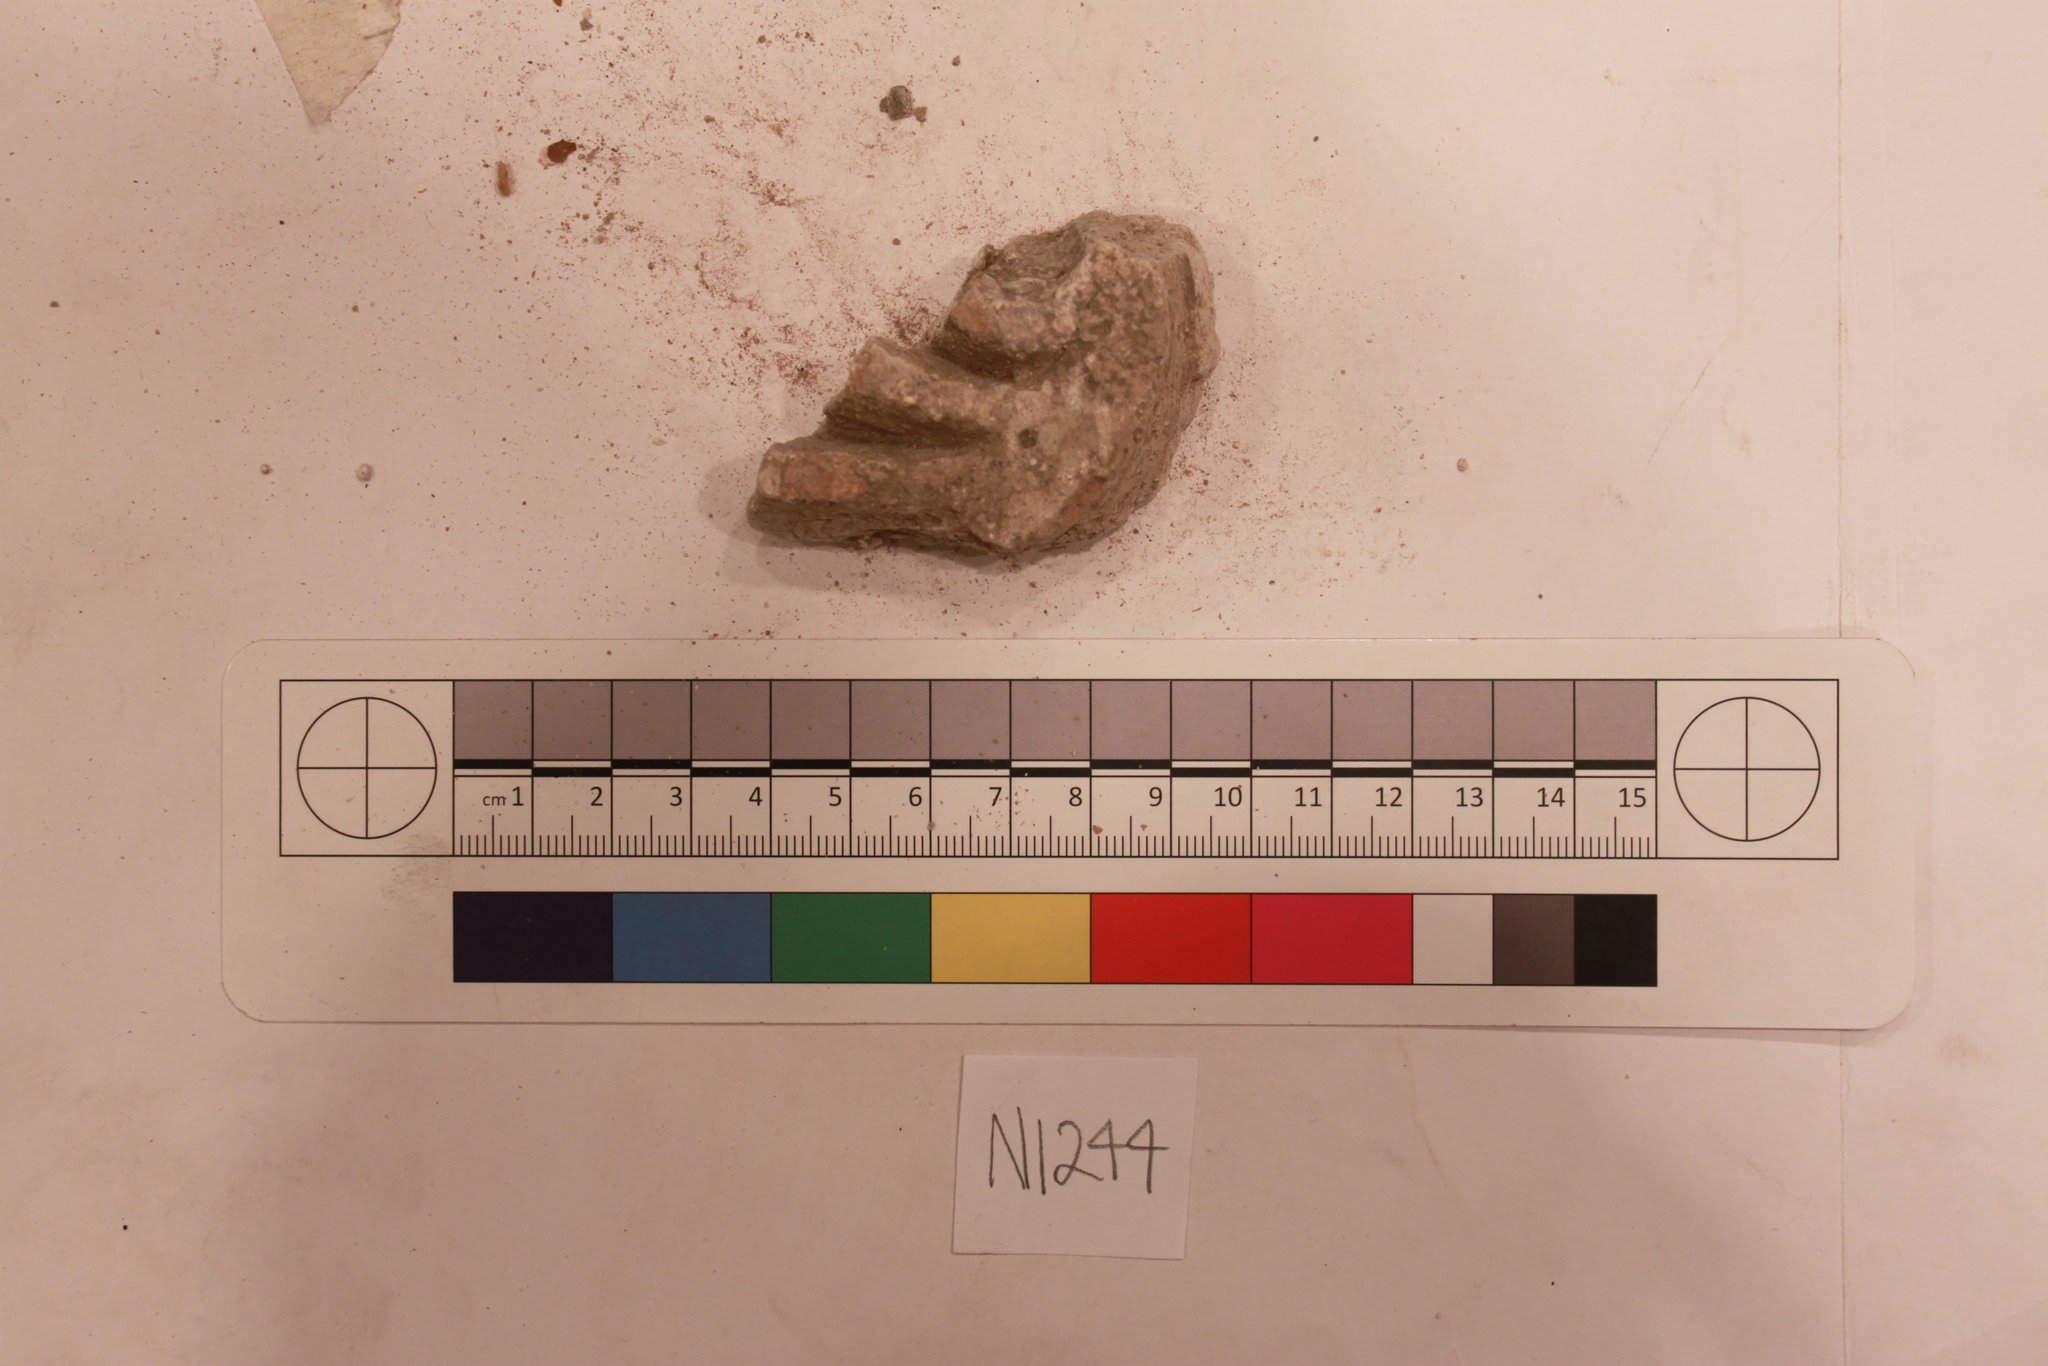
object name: fragment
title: Stucco Fragment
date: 701-1200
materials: plaster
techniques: carving, painting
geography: iran